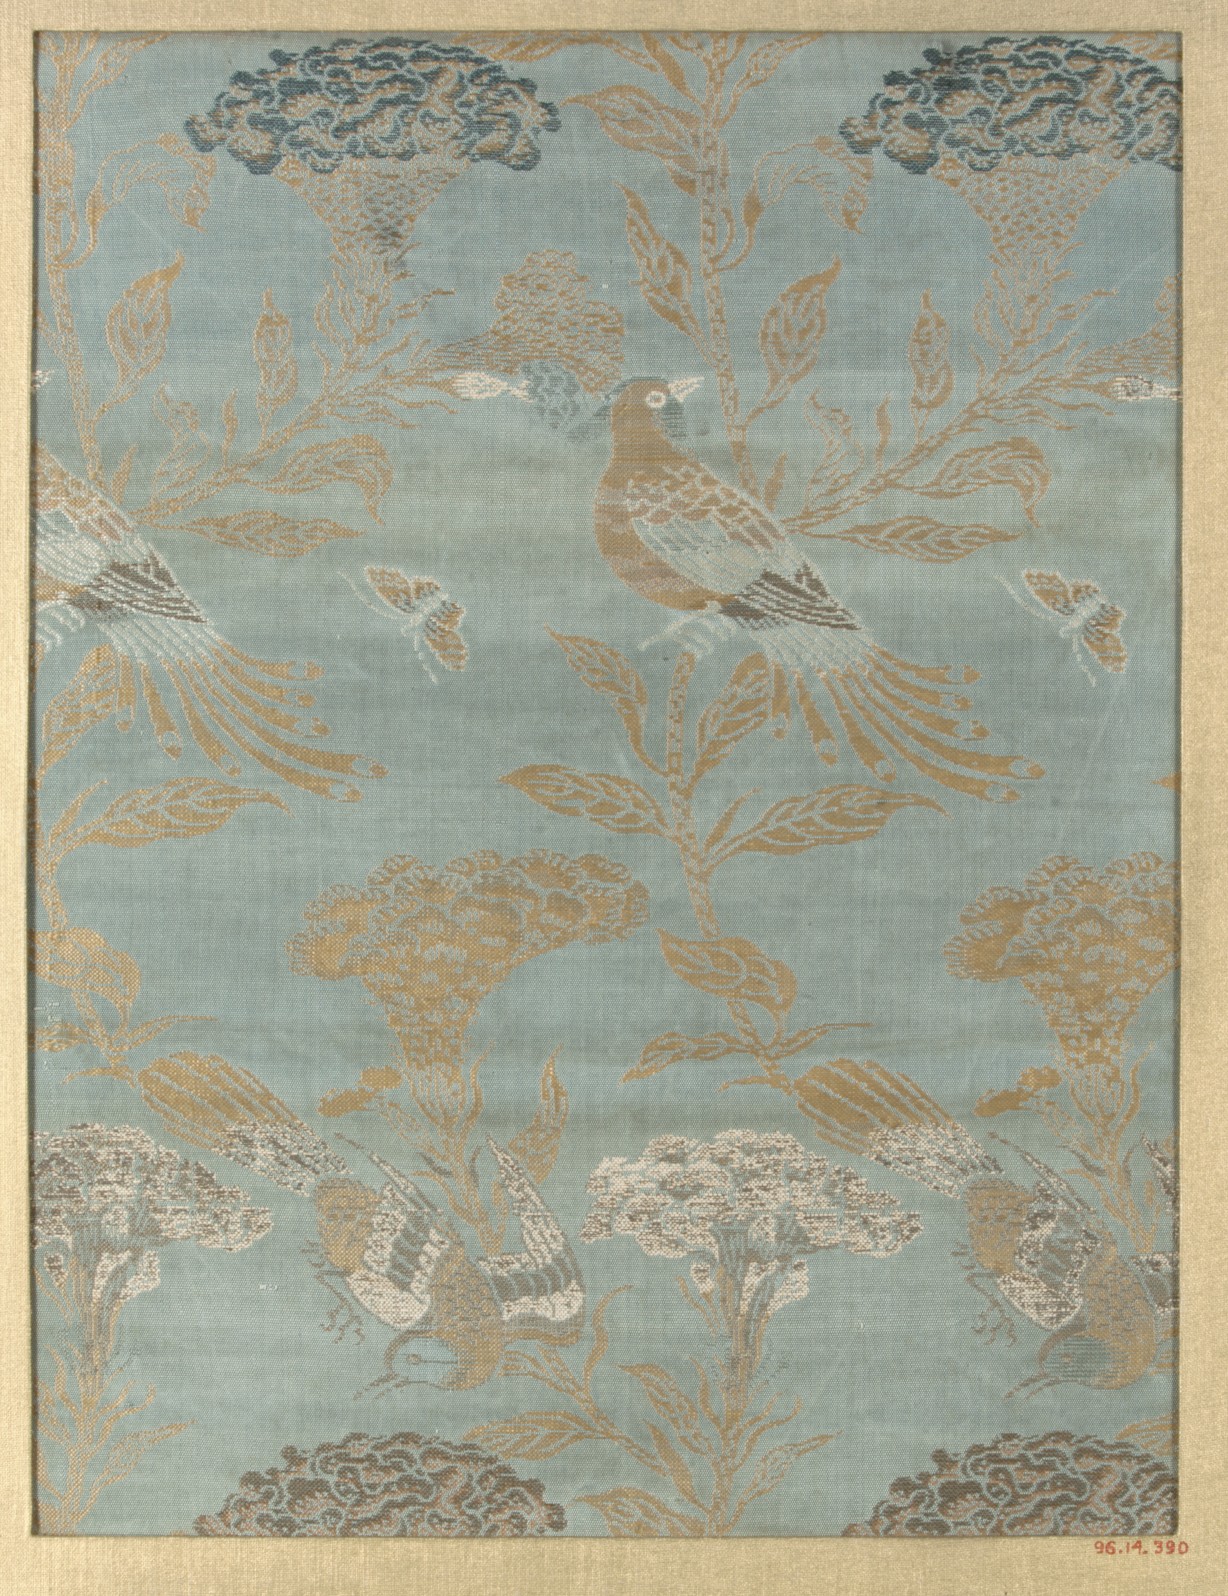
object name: piece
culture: japanese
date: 1701-1900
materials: silk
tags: butterflies,leaves